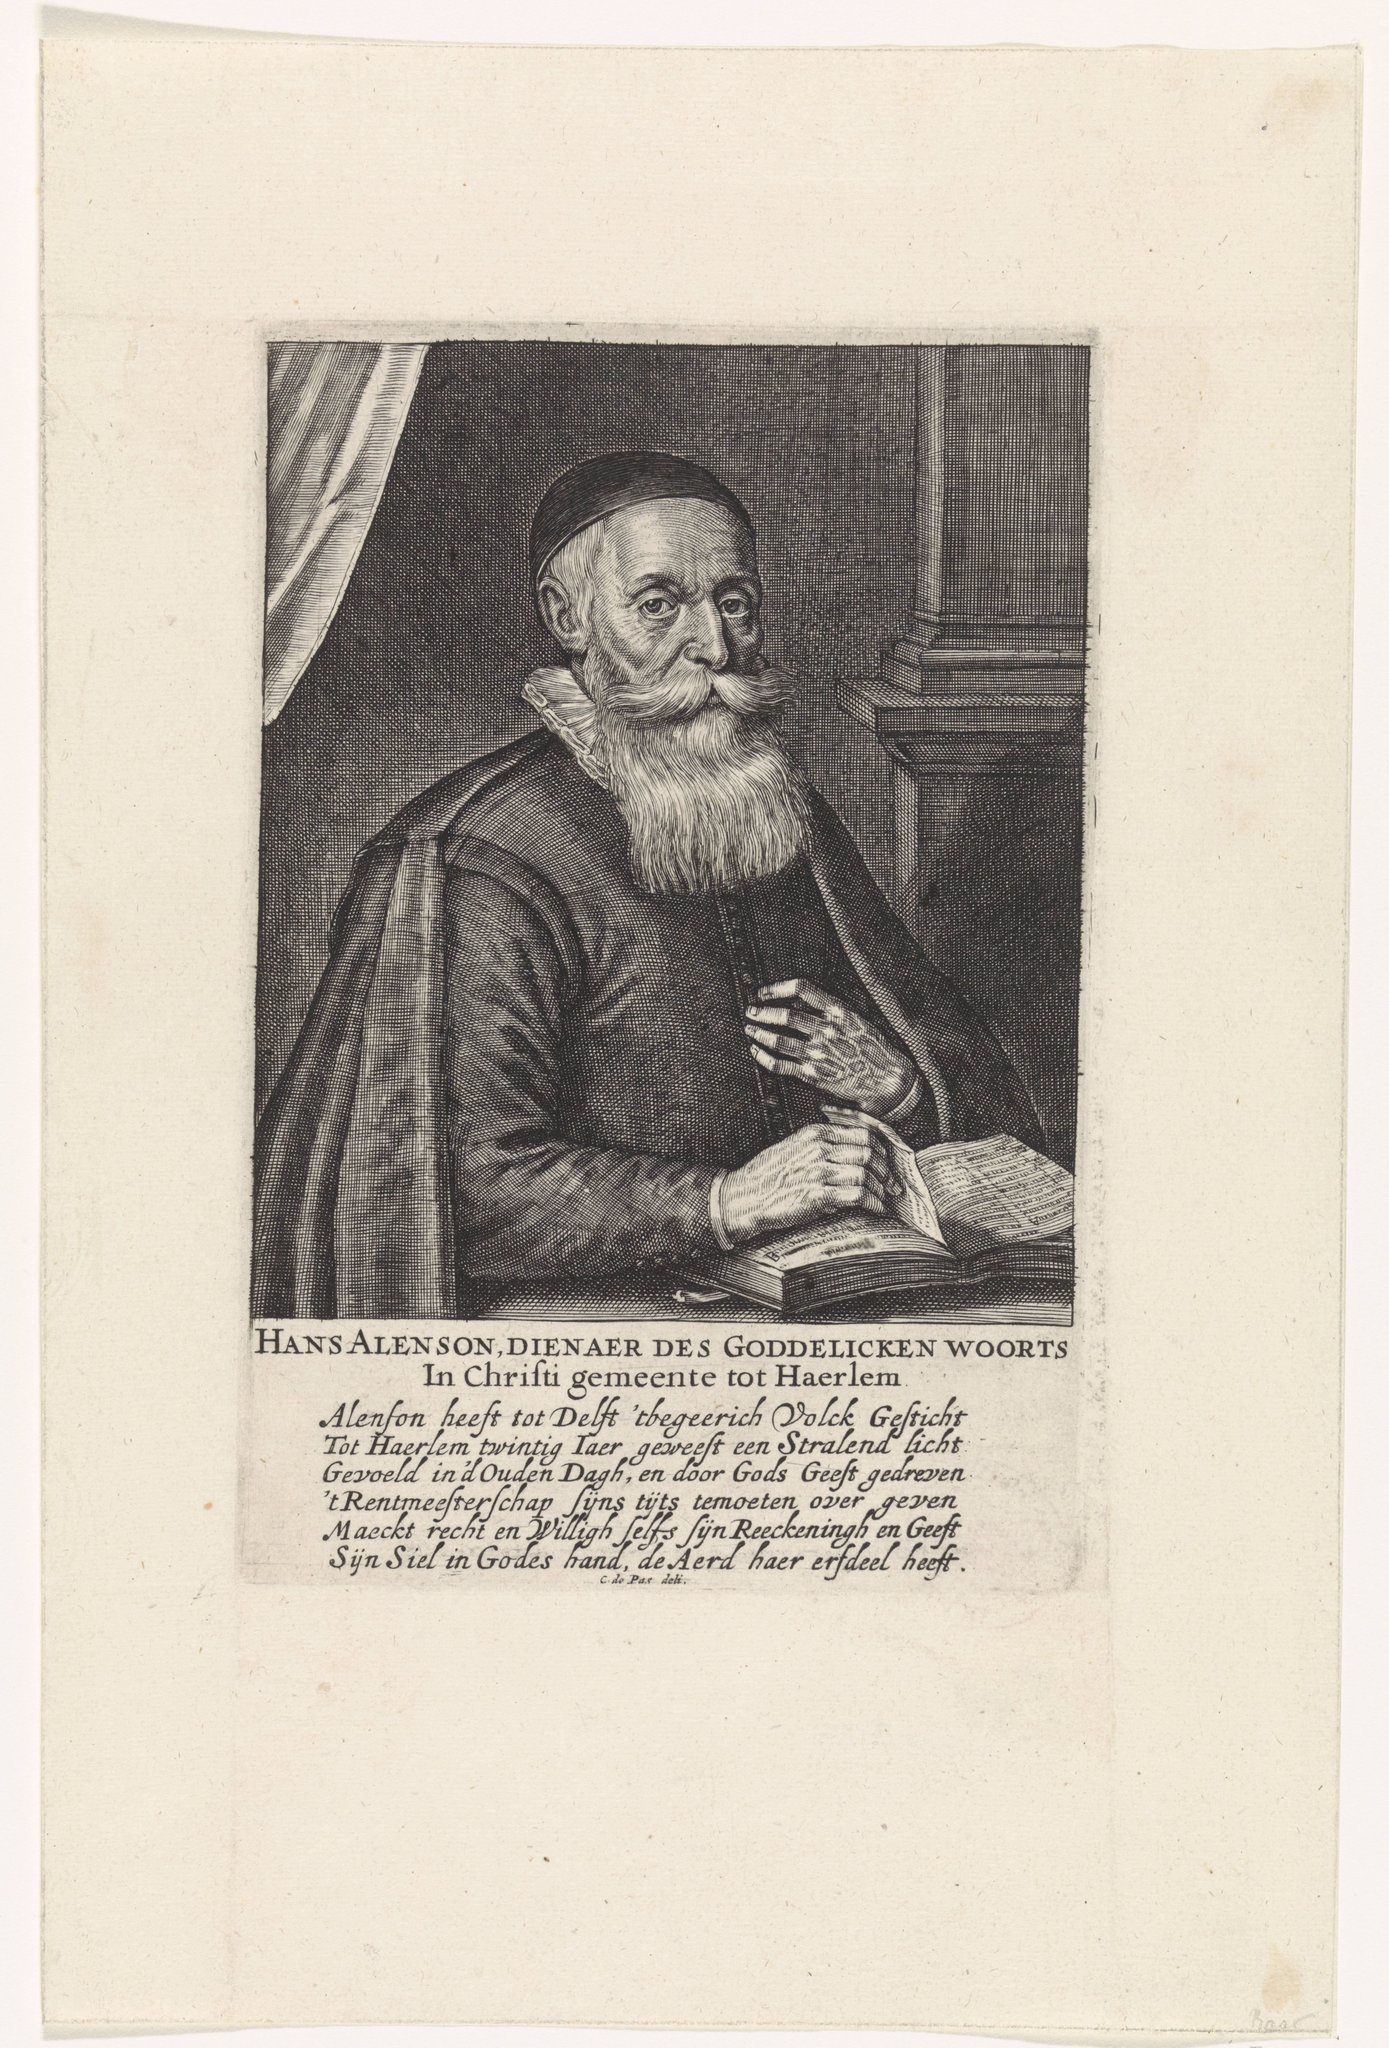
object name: print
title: Portret van Hans Alenson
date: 1604-1670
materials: paper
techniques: engraving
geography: northern netherlands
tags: haarlem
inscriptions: collector's mark: Lugt 240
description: Portret van Hans Alenson, Doopsgezinde predikant te Delft en Haarlem. In de marge de naam en functie van de geportretteerde in het Nederlands. Daaronder een zesregelig lofdicht in het Nederlands.